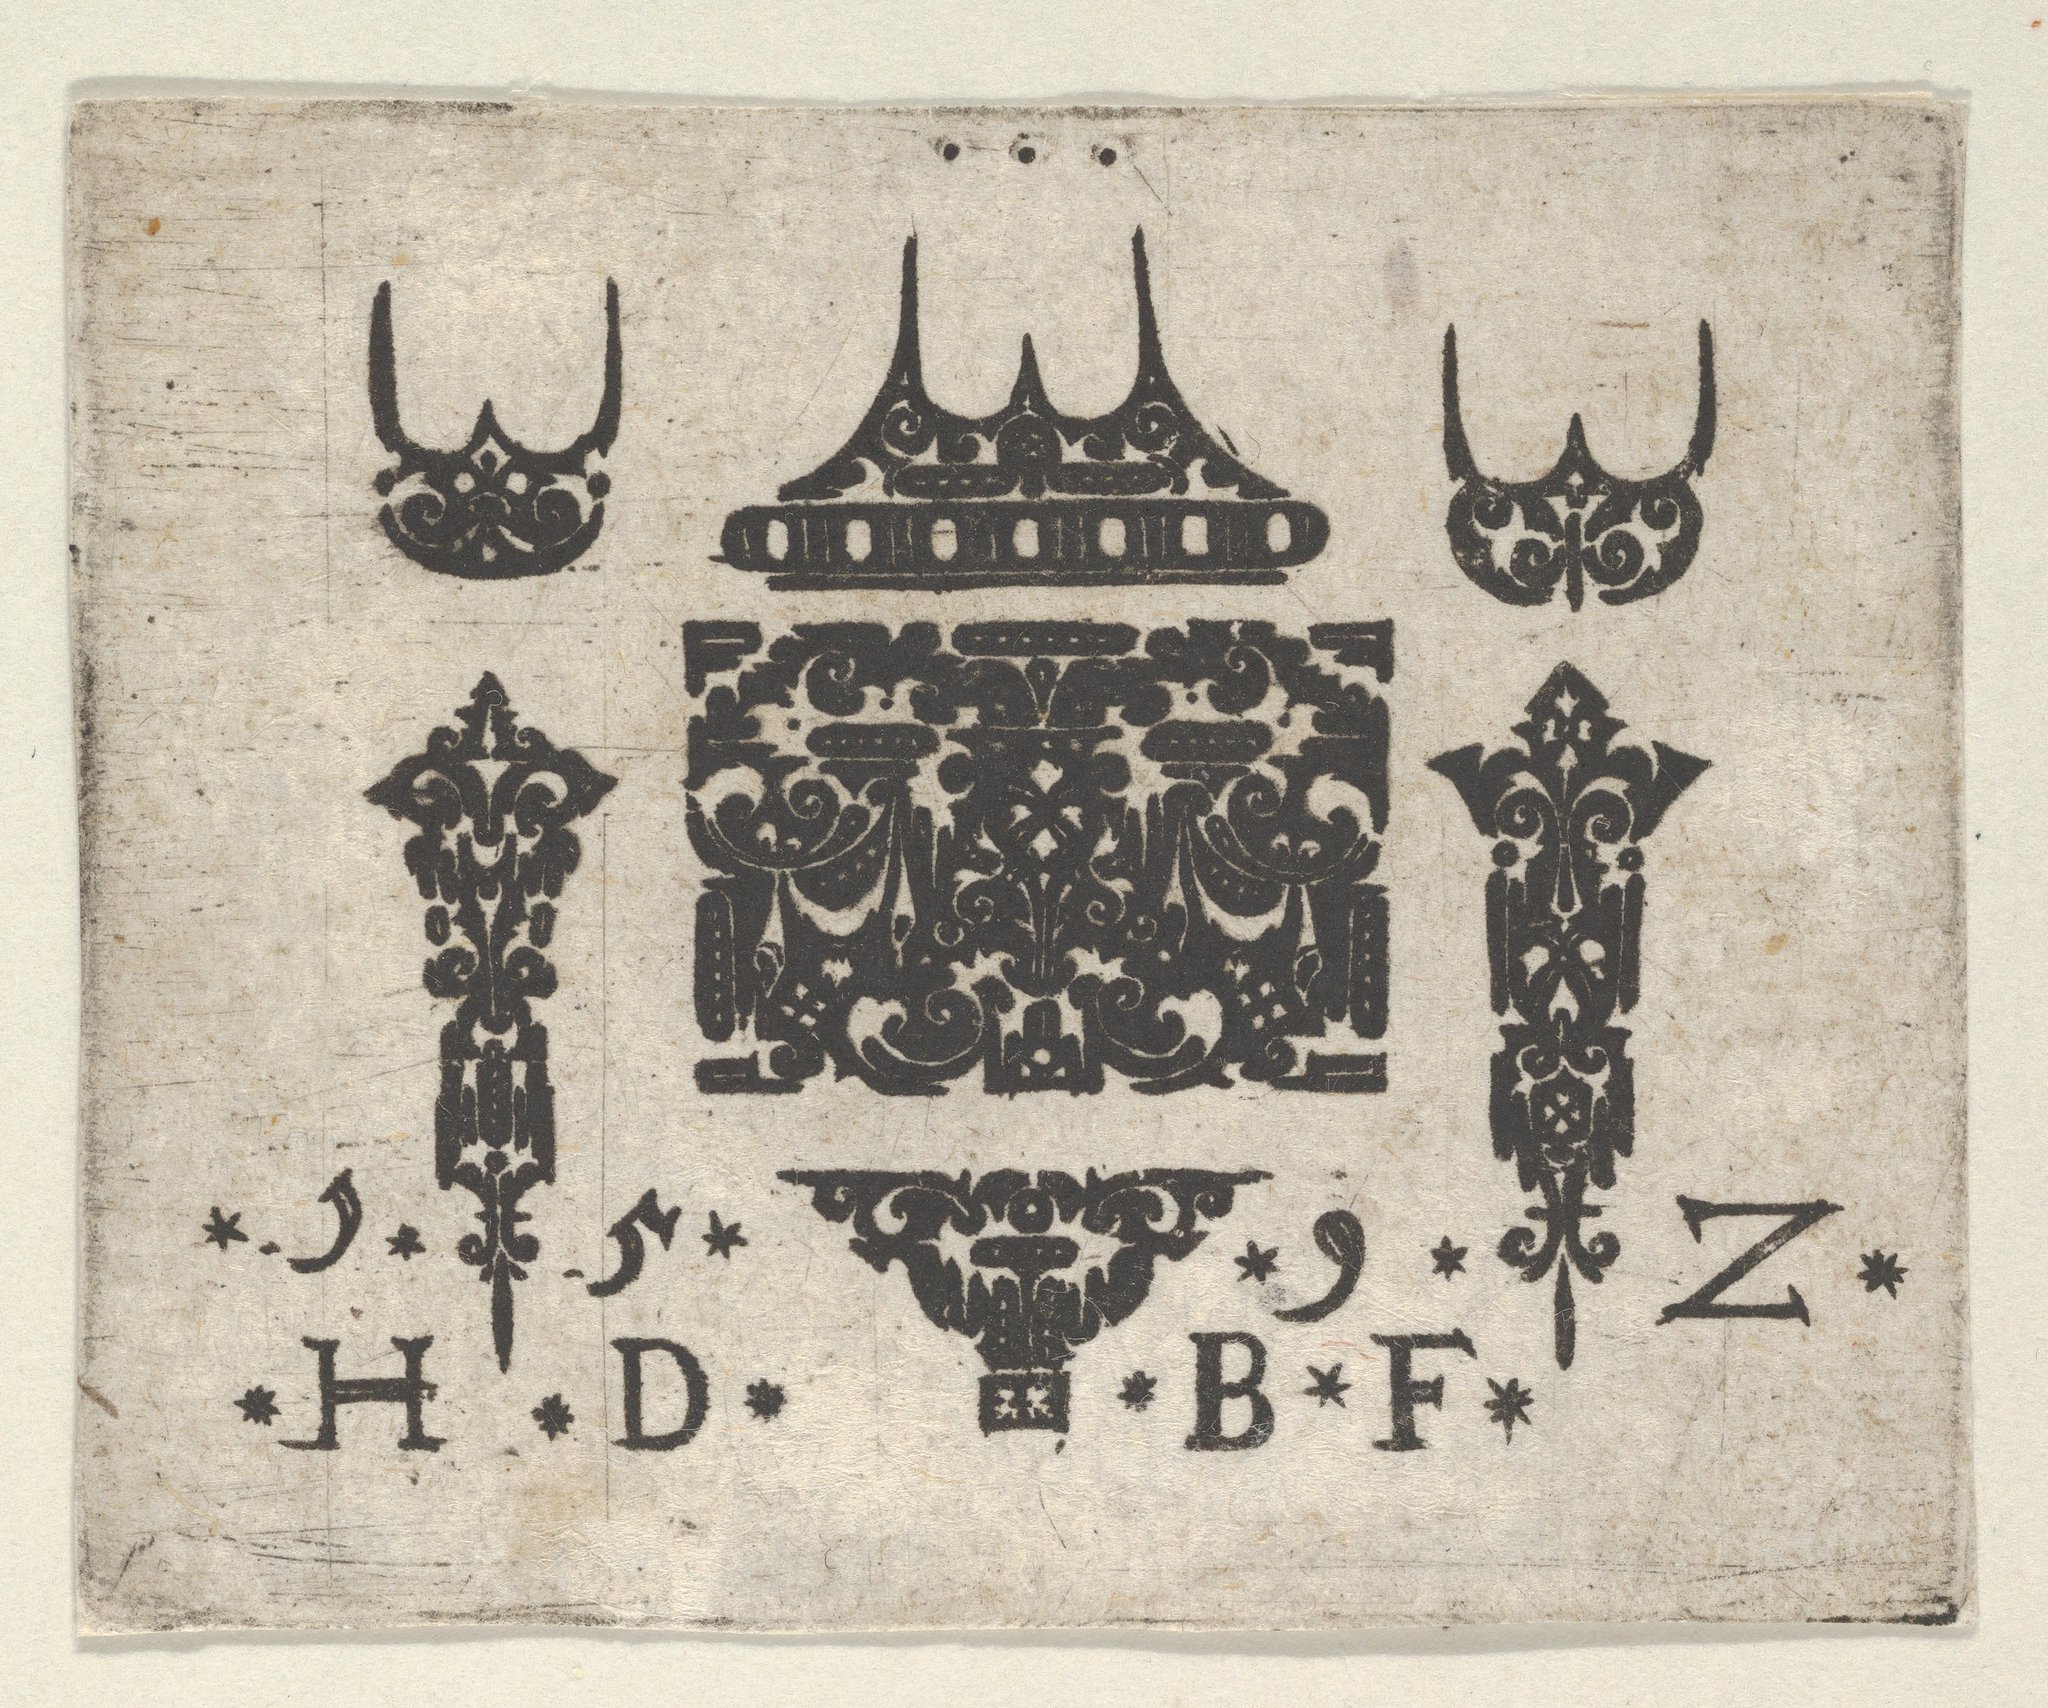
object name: print ornament architecture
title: Blackwork Print with a Horizontal Panel and Six Small Motifs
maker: hans de bull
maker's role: artist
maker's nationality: german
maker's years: 1592-1604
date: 1592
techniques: embroidery, engraving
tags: ornament